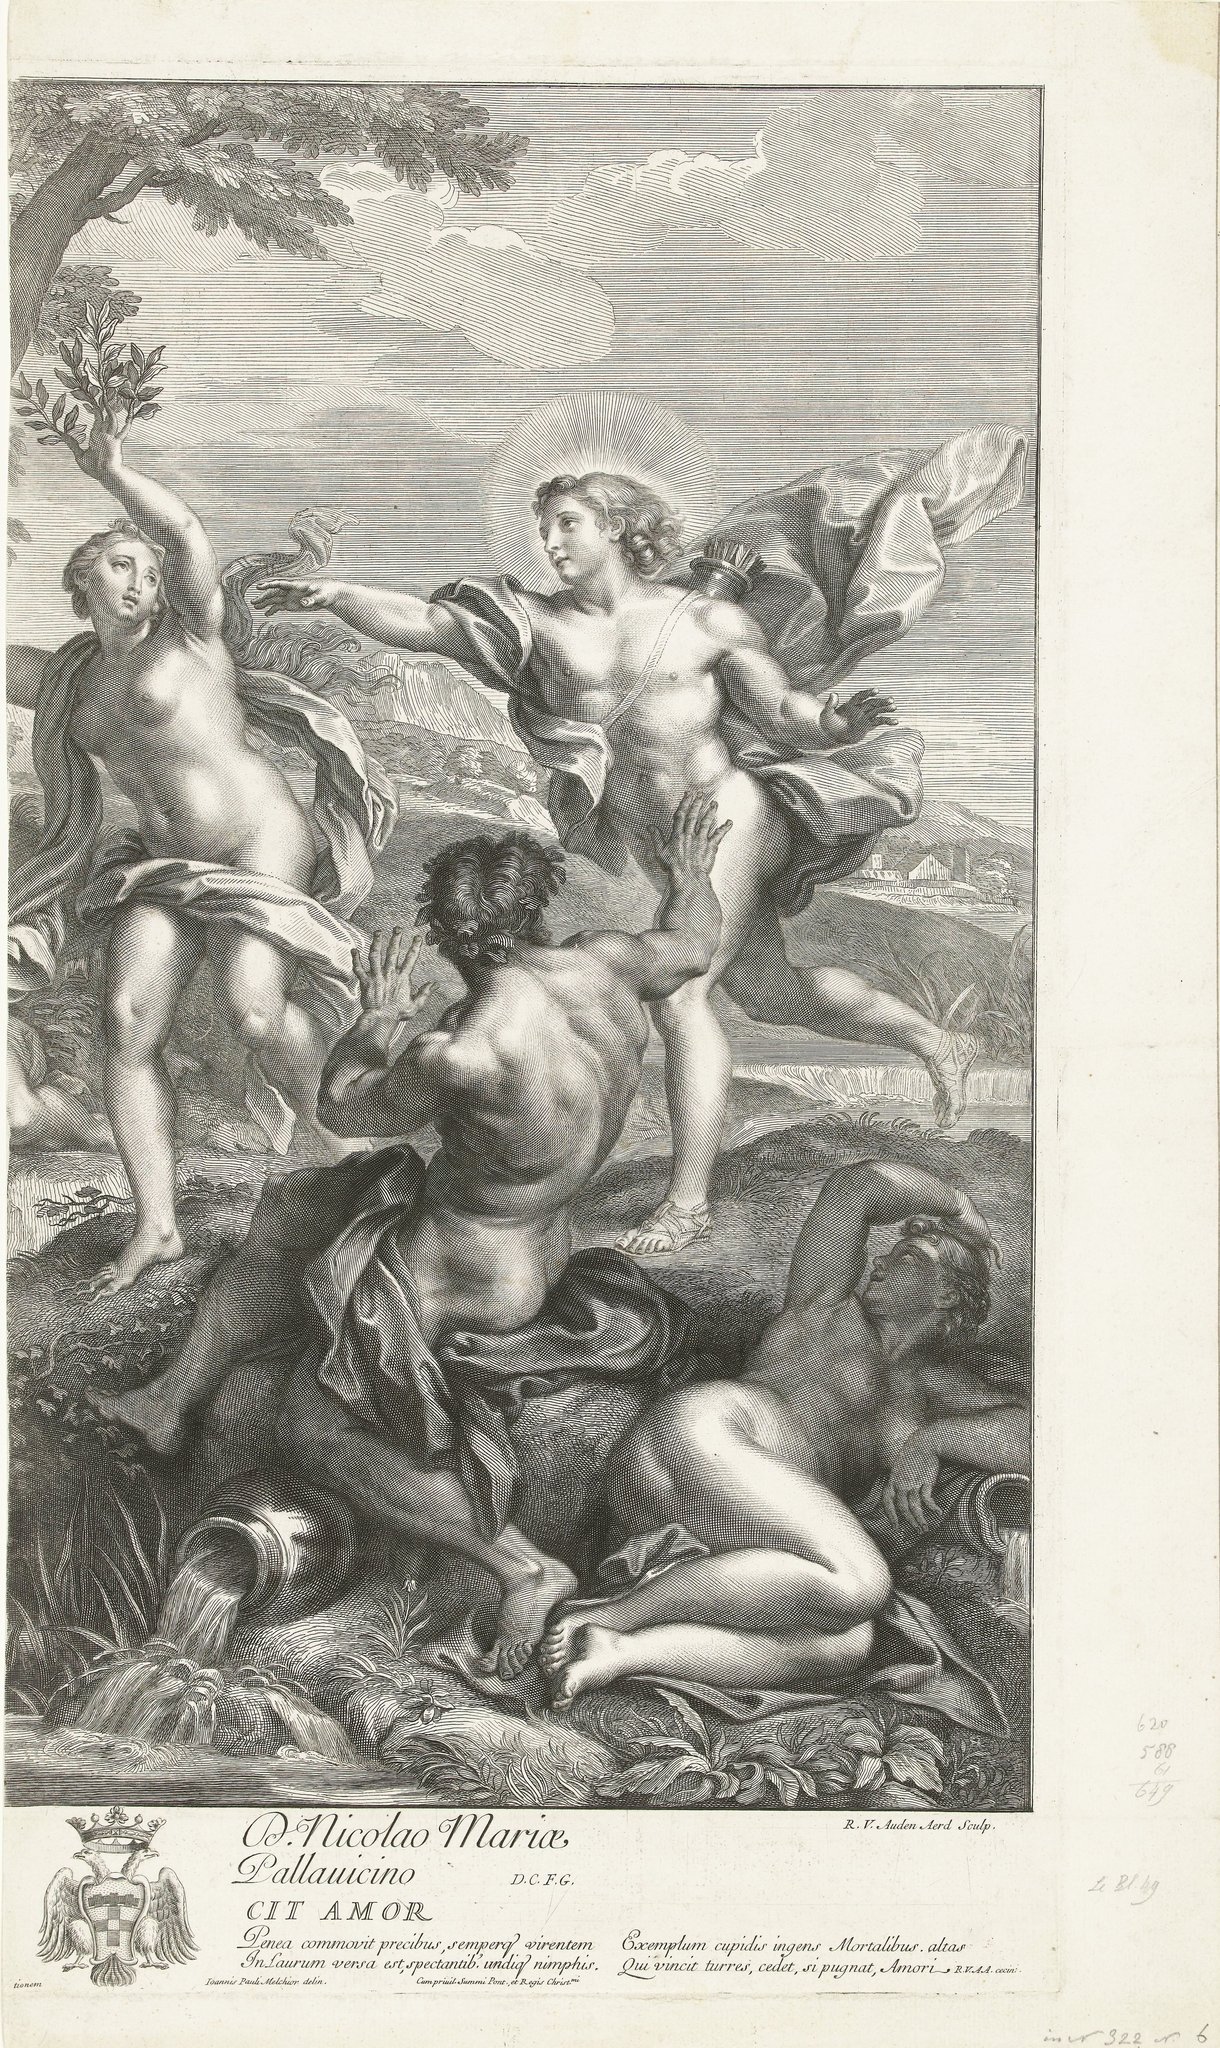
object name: print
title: Apollo en Daphne (rechter deel)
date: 1685-1728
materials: paper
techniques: engraving, etching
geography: rome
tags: apollo pursuing the nymph daphne (as yet not metamorphosed), daphne changed into a laurel-tree: while fleeing from apollo, daphne is changed into a laurel-tree by her father peneus (ovid, metamorphoses i 548)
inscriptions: collector's mark: Lugt 240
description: Apollo, door een van Amors pijlen getroffen, achtervolgd de nimf Daphne. Die roept haar vader om hulp en vervolgens veranderd ze in een laurierboom. Uit haar vingers sprieten al de bladeren. Een riviergod en een nimf die aan de oever van een rivier liggen zien het geheel gebeuren.